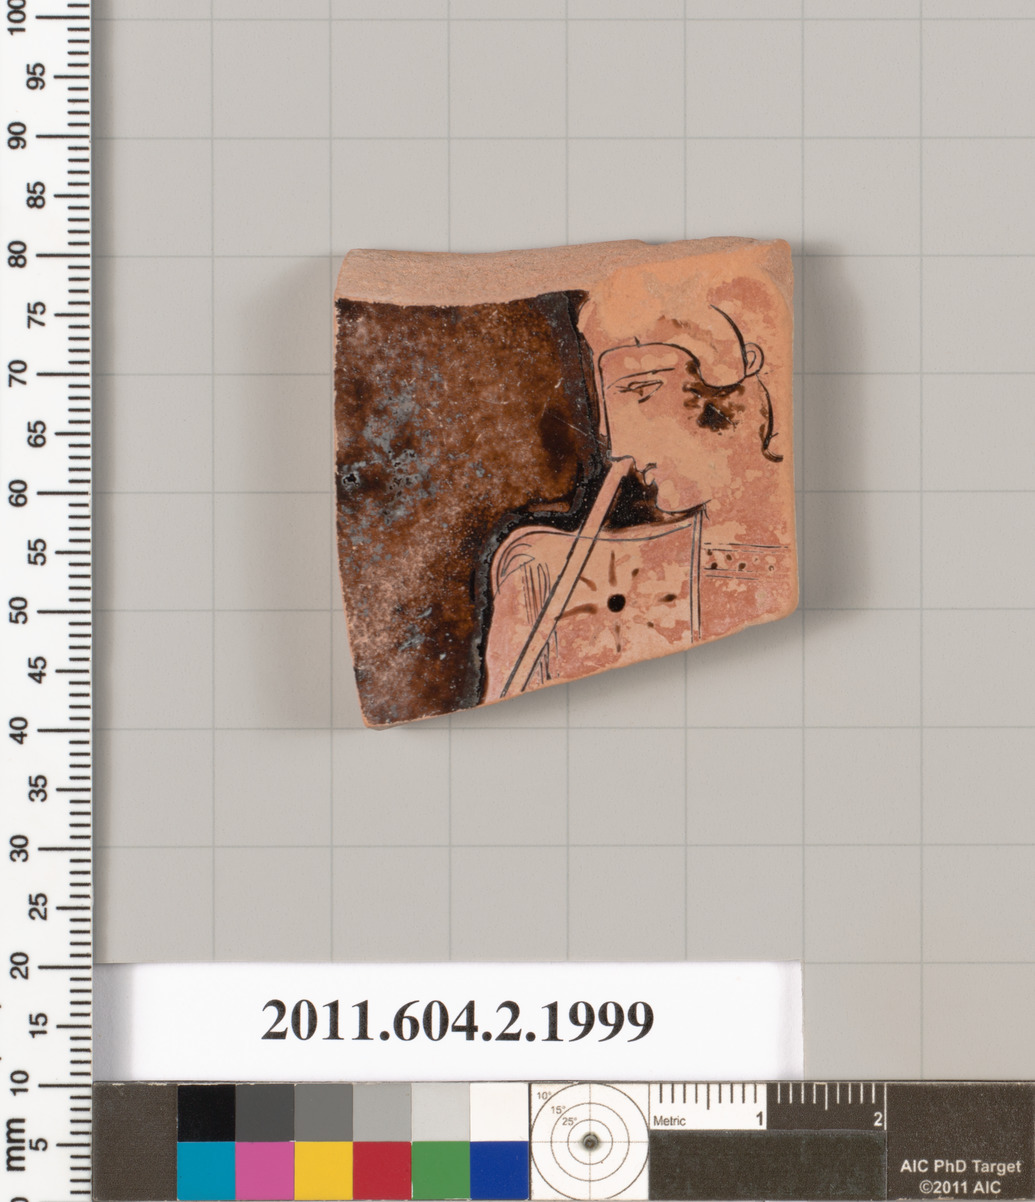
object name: pot fragment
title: Terracotta fragment of a pot; glazed on the inside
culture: greek, attic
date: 450-440 BCE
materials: terracotta